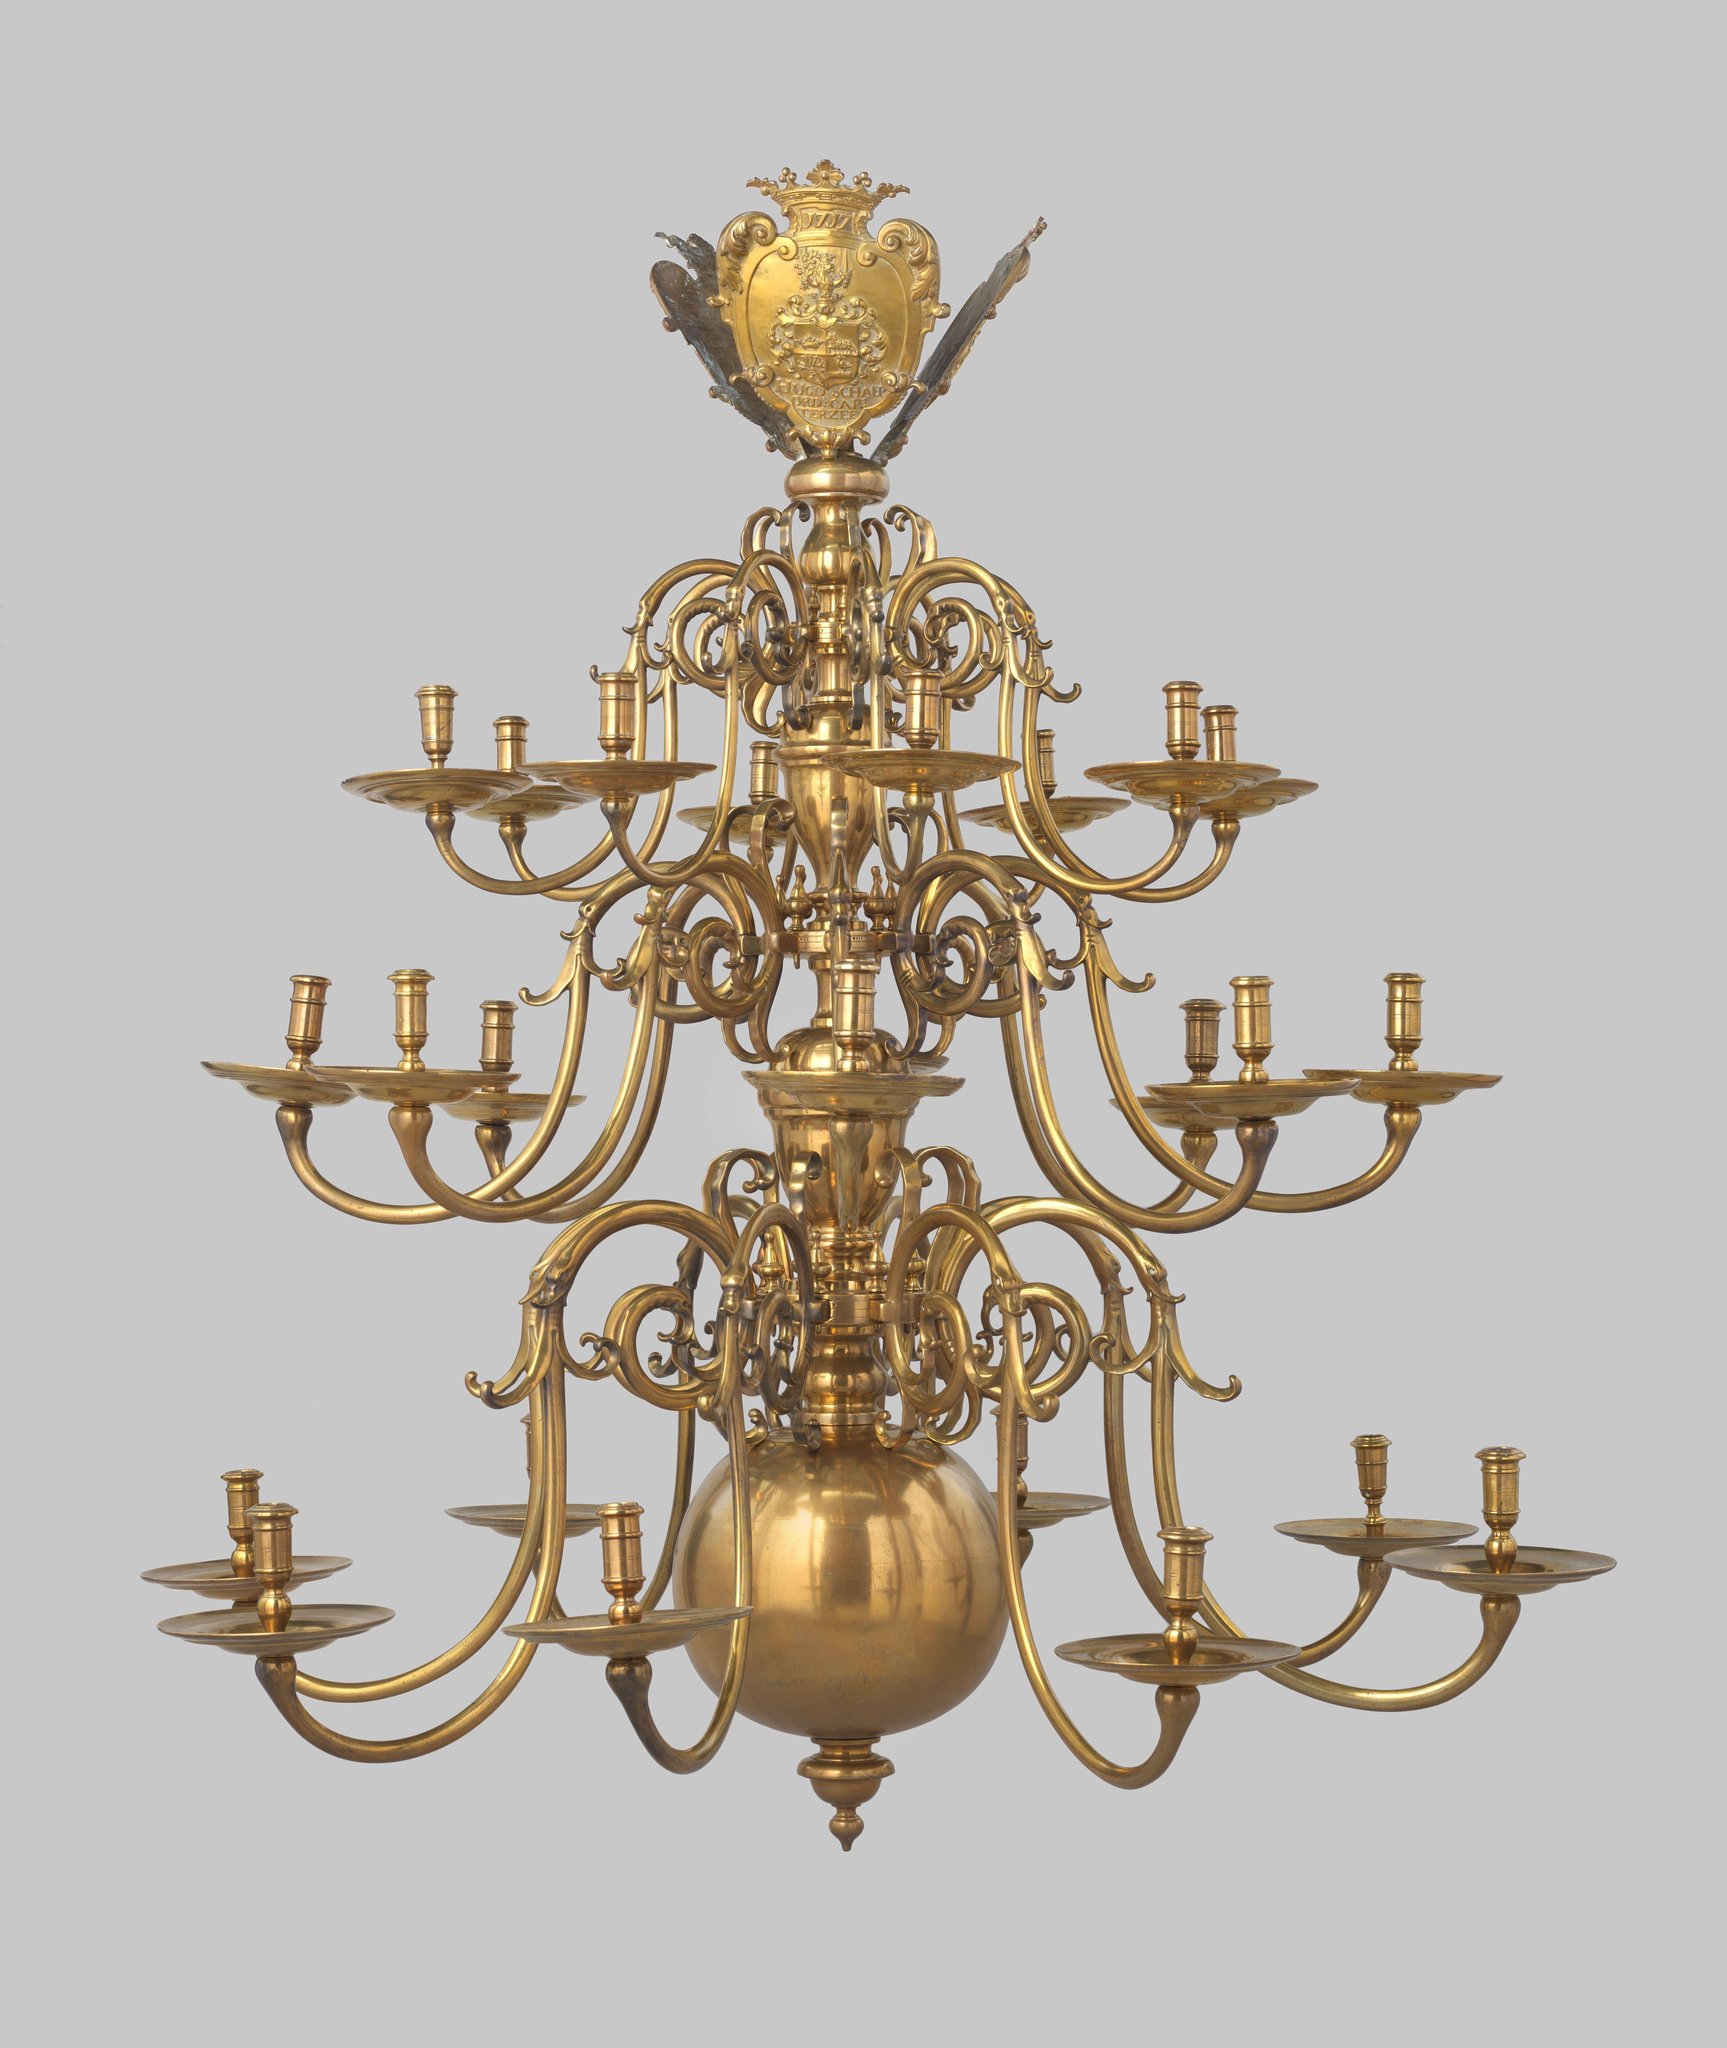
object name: chandelier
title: Arm van een kaarsenkroon in drie hoogten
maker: Anonymous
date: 1717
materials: brass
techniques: casting, screwed, turning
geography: amsterdam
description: De S-vormige arm is aan de stamzijde voorzien van een nok om deze met een pin in de standring te kunnen vastzetten. Bij de stam is de arm op het eind en naar het midden toe versierd met twee gestileerde dolfijnenkoppen en met krullen, waarvan de vorm aan het kwabornament is ontleend. Naar buiten toe eindigt de arm in een verdikking, waarin een van een schroefdraad voorzien gat is aangebracht ter bevestiging van de kaarsenhouder op de vetvanger. De arm is met behulp van hetzelfde model gegoten als de overige armen van de krans. De kaarsenhouder is cylindervormig met geprofileerd uitstekende rand en met een balustervoet, welke overgaat in een van een schroefdraad voorzien eind, waarin onderaan het centergat. De vetvanger is aan de bovenkant naar het midden toe twee keer verdiept. Aan de onderkant is deze rond het gat in het enigszins bolvormige midden geprofileerd en is de rand geribd. De vetvanger met behulp van hetzelfde model gegoten als de overige vetvangers van deze krans. De pin is voorzien van een vaasvormige knop. Dit is de derde arm van de bovenste standring, genummerd op de nok met het cijfer III.